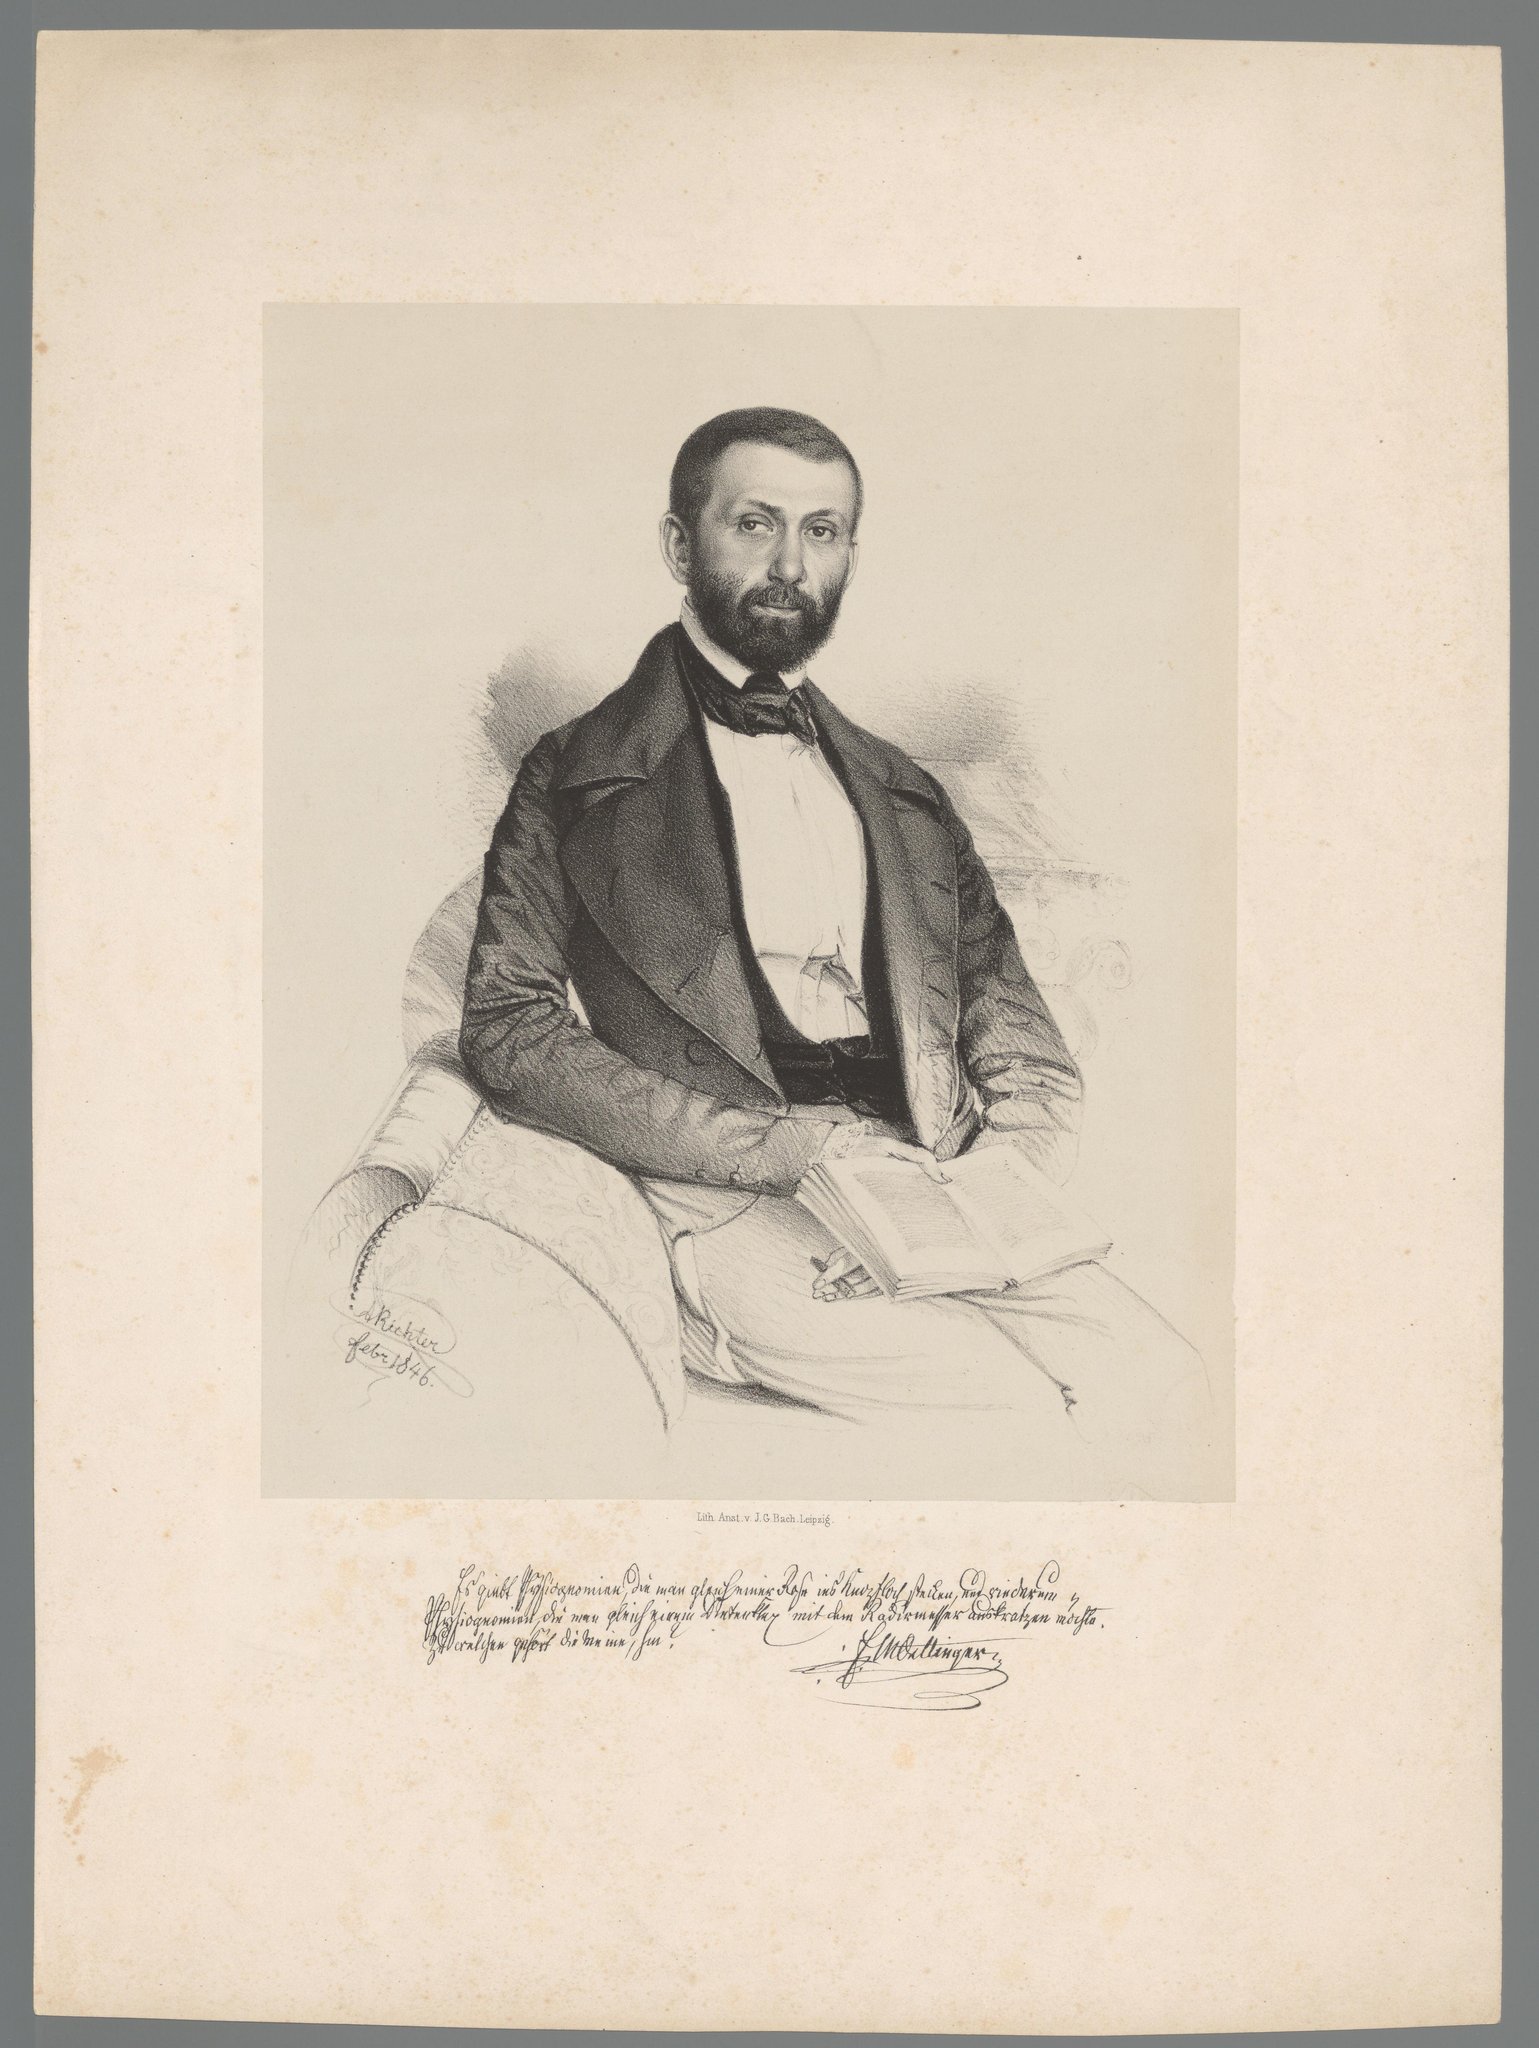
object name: print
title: Portret van Eduard Maria Oettinger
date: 1846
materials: paper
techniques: lithograph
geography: leipzig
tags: historical persons, portrait of a writer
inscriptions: collector's mark: Lugt 2228